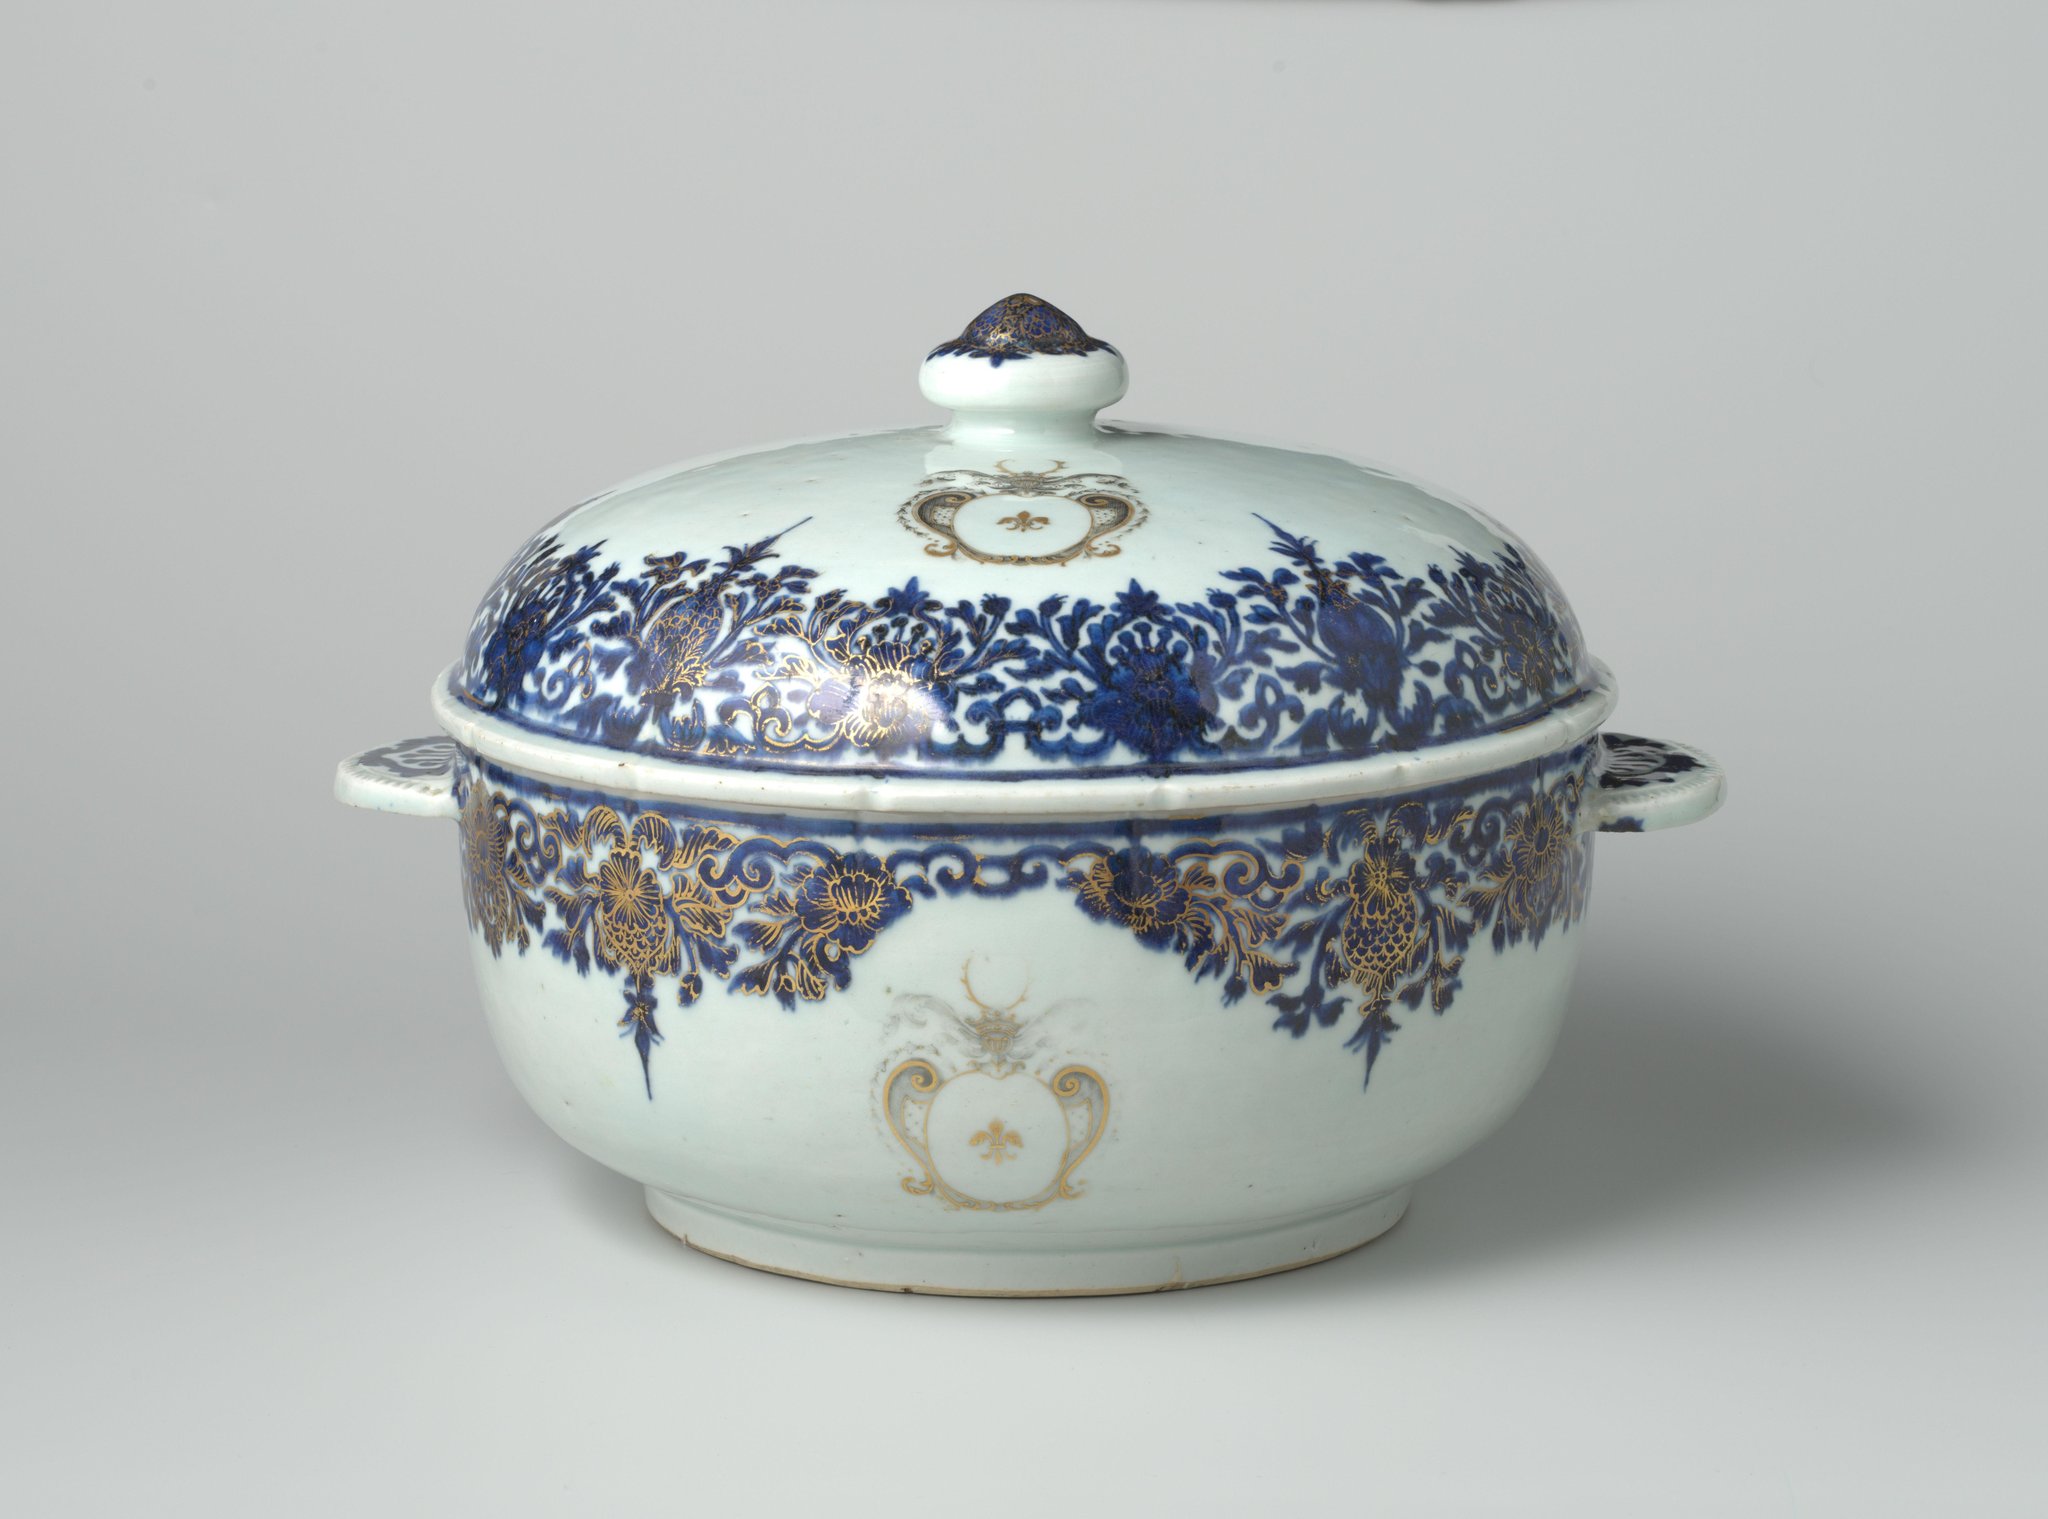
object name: tureen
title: Terrine met het wapen van de familie Swellengrebel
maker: Anonymous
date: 1740-1750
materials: cobalt, glaze, gold, paint, porcelain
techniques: firing, gilding, turning, vitrification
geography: china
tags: utrecht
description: Ronde terrine op een voetring, met twee kleine schelpvormige oren; een bolle deksel met puntige dekselknop. Beschilderd in onderglazuur blauw en met zwart en goud op het glazuur. Rond de dekselrand en de bovenzijde van de kom een brede rand met bandwerk en bloemranken in blauw met goud. Op het deksel en de kom tweemaal het wapen van de familie Swellengrebel in zwart en goud: Franse lelie op een ovaal schild en een gewei boven een kroon als helmteken. Wapenporselein in blauw-wit en emailkleuren.